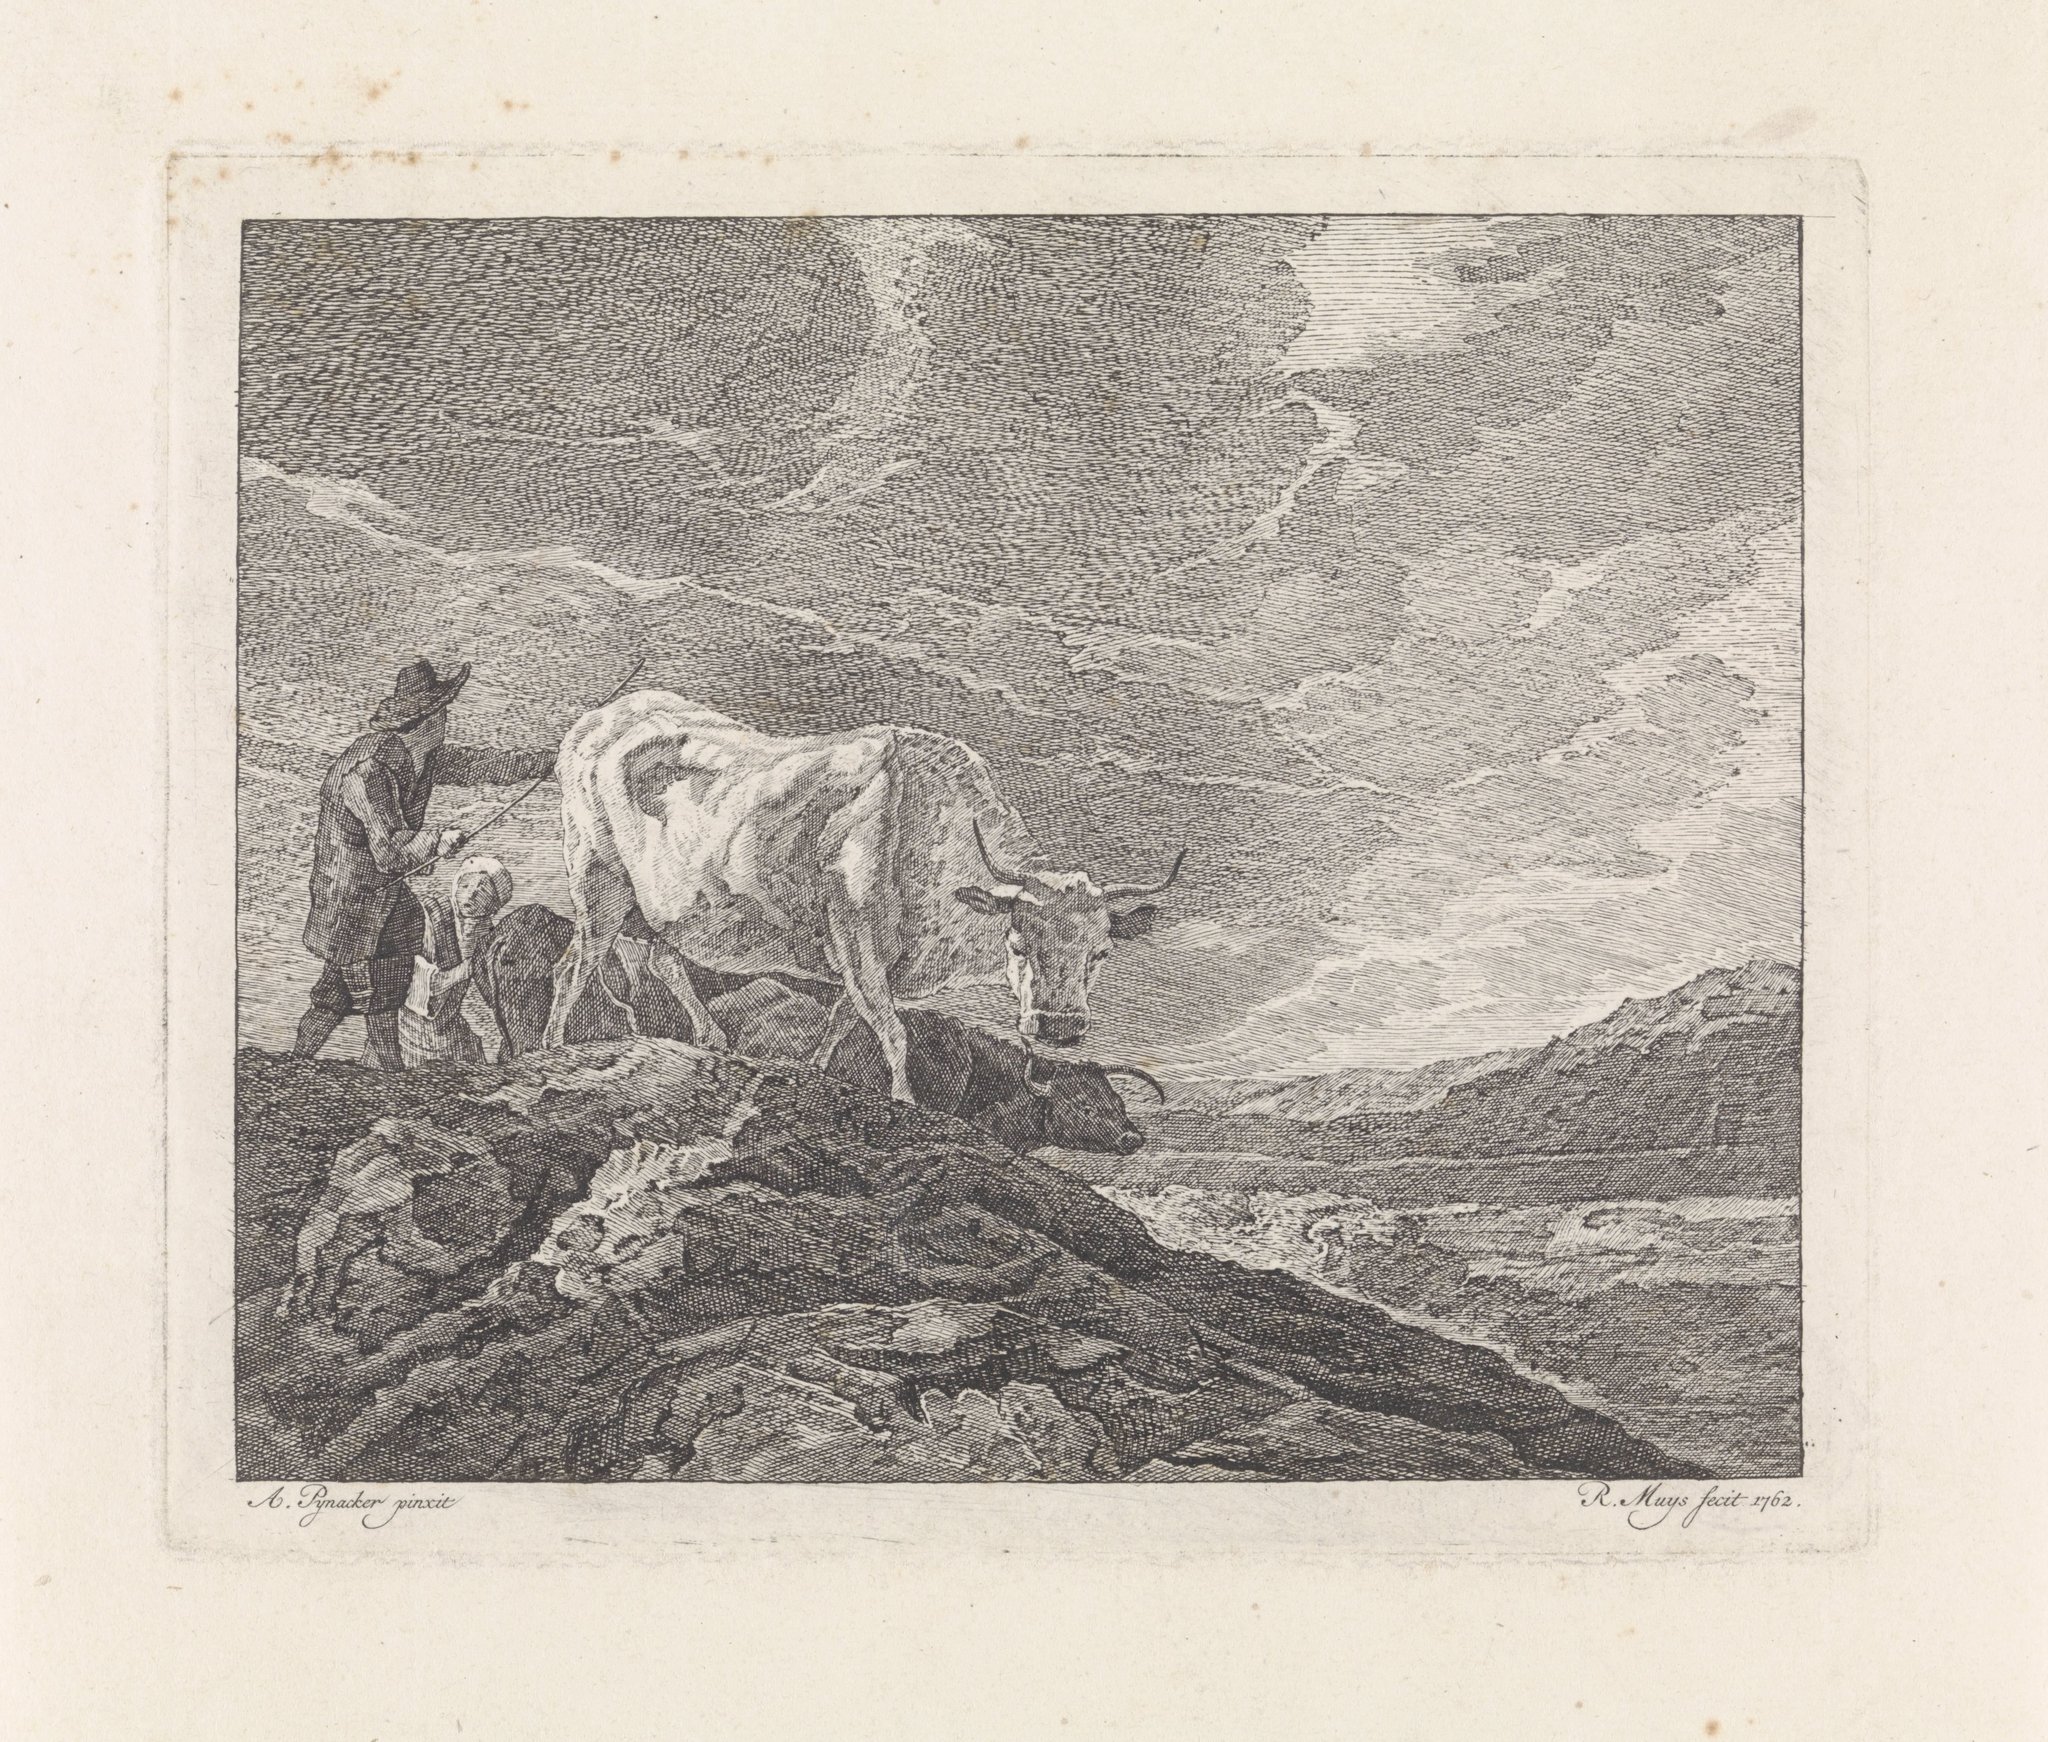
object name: print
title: Drijven van de koeien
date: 1762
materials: paper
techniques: etching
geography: rotterdam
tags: herd, flock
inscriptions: collector's mark: Lugt 240